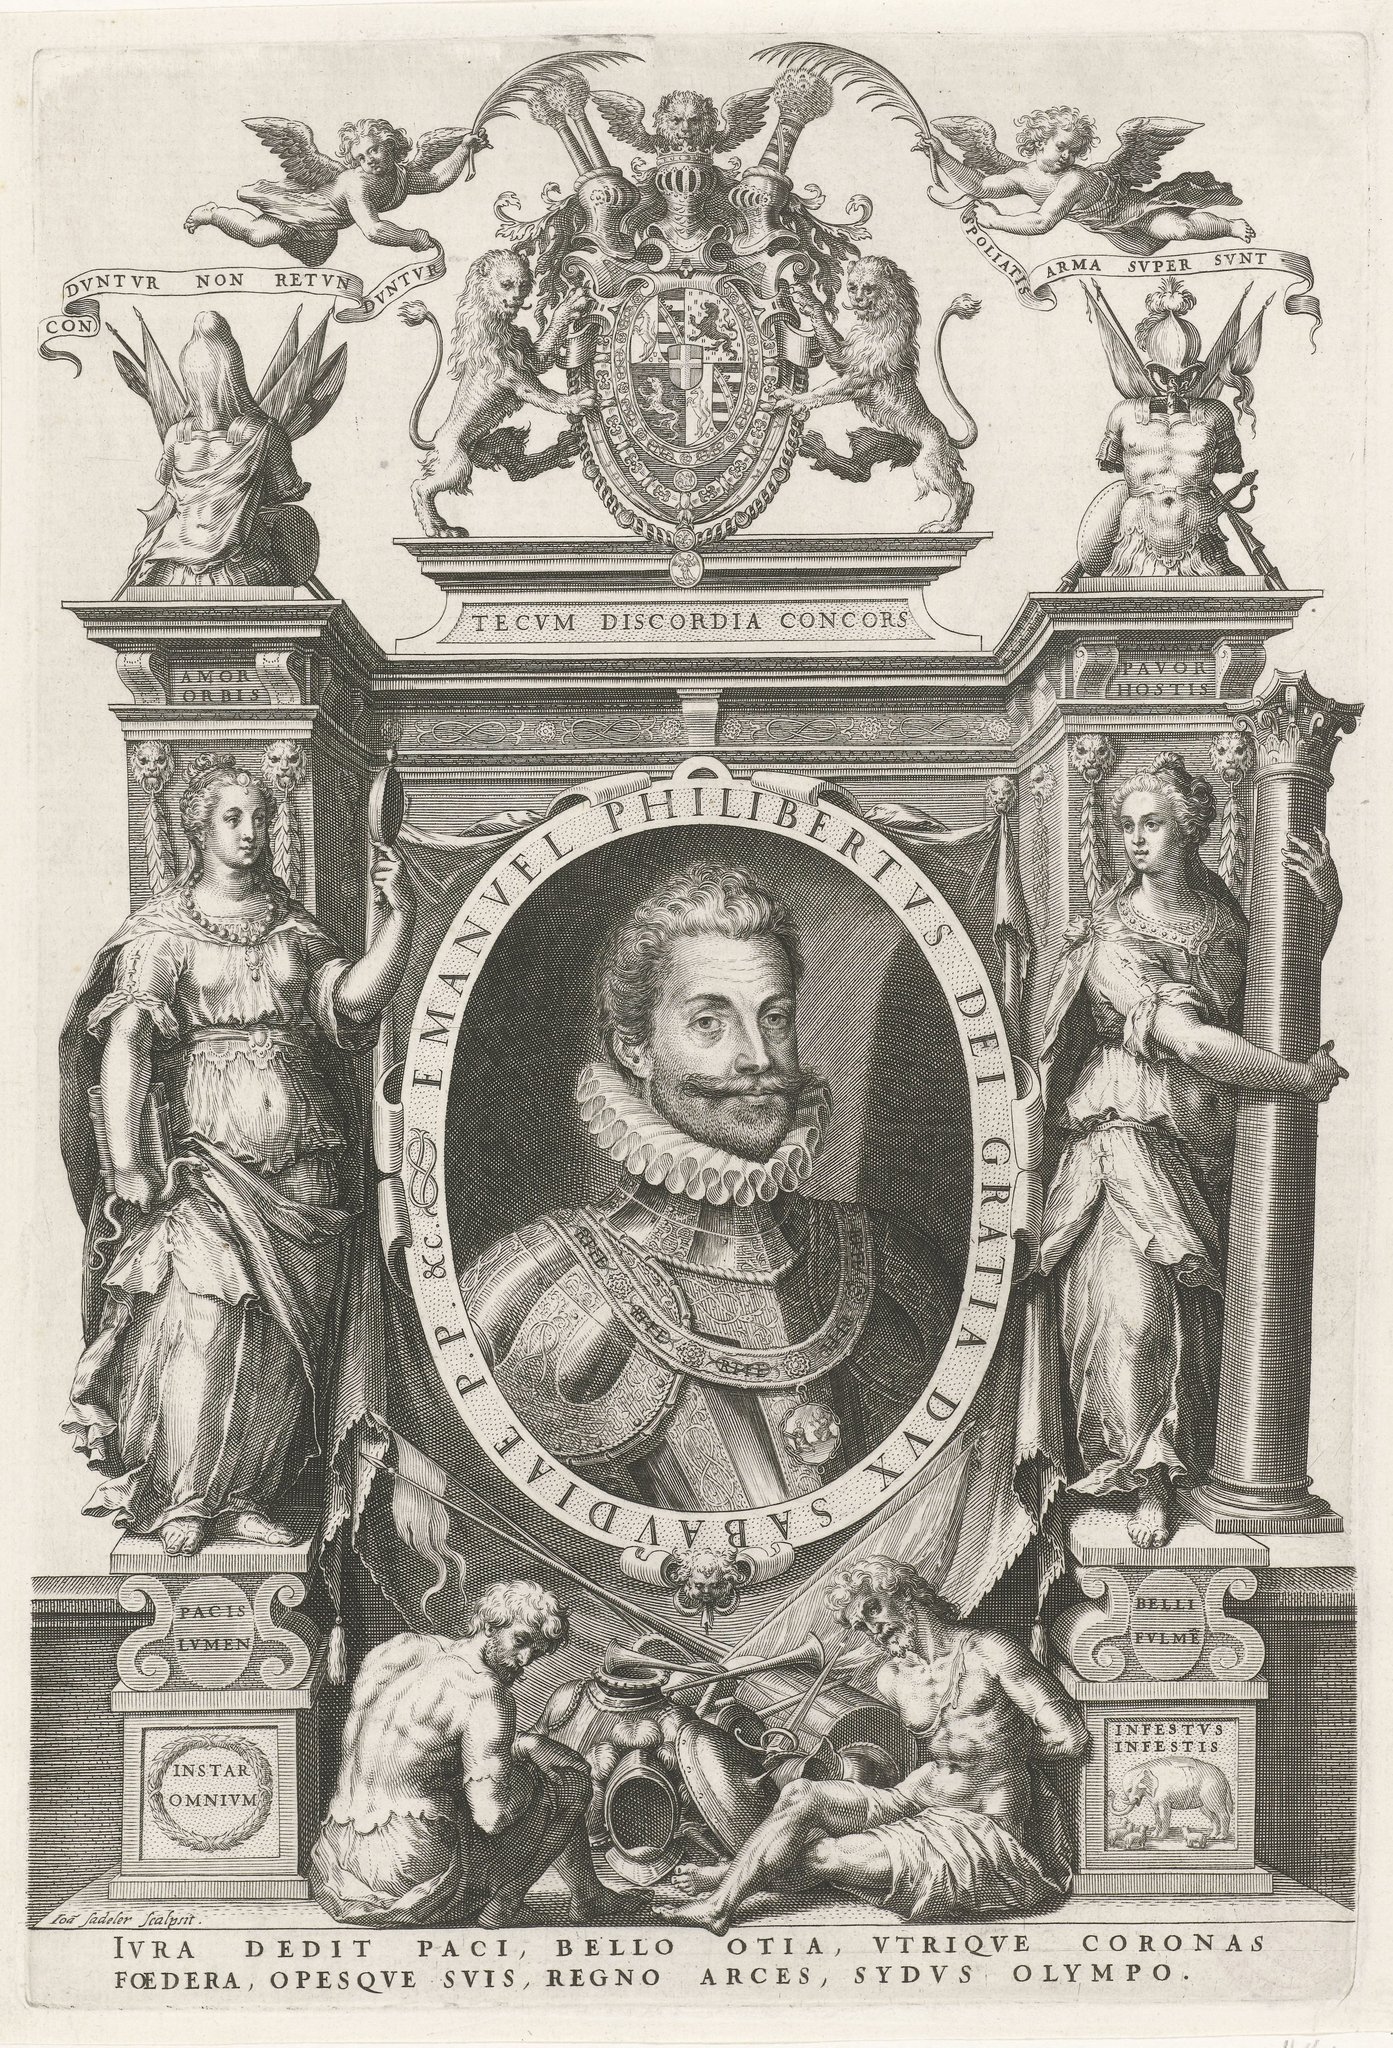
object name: print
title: Portret van Emanuel Philibert, hertog van Savoye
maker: johann sadeler (i)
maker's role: print maker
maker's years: 1550-1600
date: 1595-1596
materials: paper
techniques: engraving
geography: italy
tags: emanuel filibert (hertog van savoye), fortitude, 'fortitudo' ~ one of the four cardinal virtues, prudence, 'prudentia'; 'prudenza' (ripa) ~ one of the four cardinal virtues, armorial bearing, heraldry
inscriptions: collector's mark: Lugt 240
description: Emanuel Philibert, hertog van Savoye. Portret in ovale cartouche met rechts de personificatie Kracht (Fortitudo) en links de personificatie Voorzichtigheid (Prudentia). Boven het portret het wapen van Savoye met het motto: 'Te cum discordia concors'. Onder het portret gevangenen.